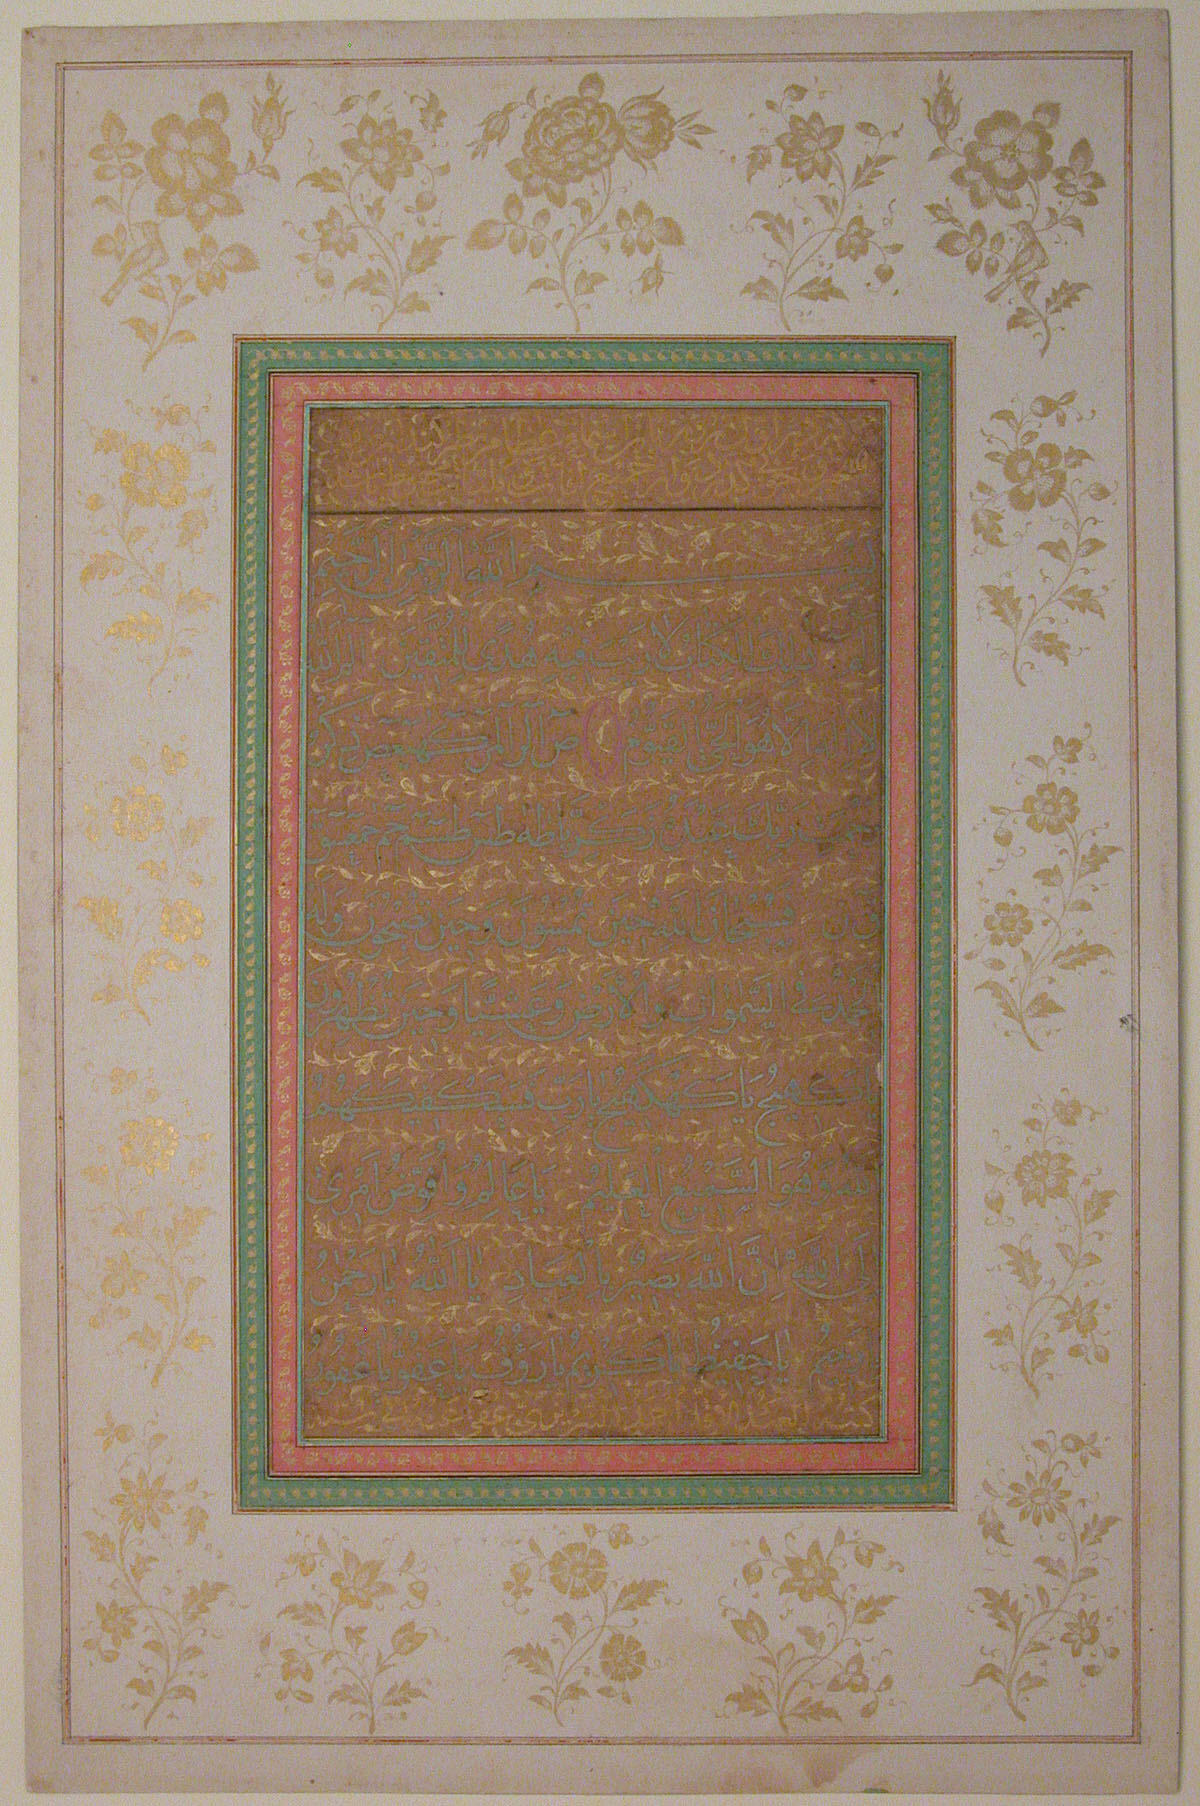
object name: non illustrated album leaf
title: Leaf with Arabic Prayers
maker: ahmad nairizi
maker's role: calligrapher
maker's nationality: iranian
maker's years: 1657-1764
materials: gold, ink, paper, watercolor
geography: iran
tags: arabic,calligraphy